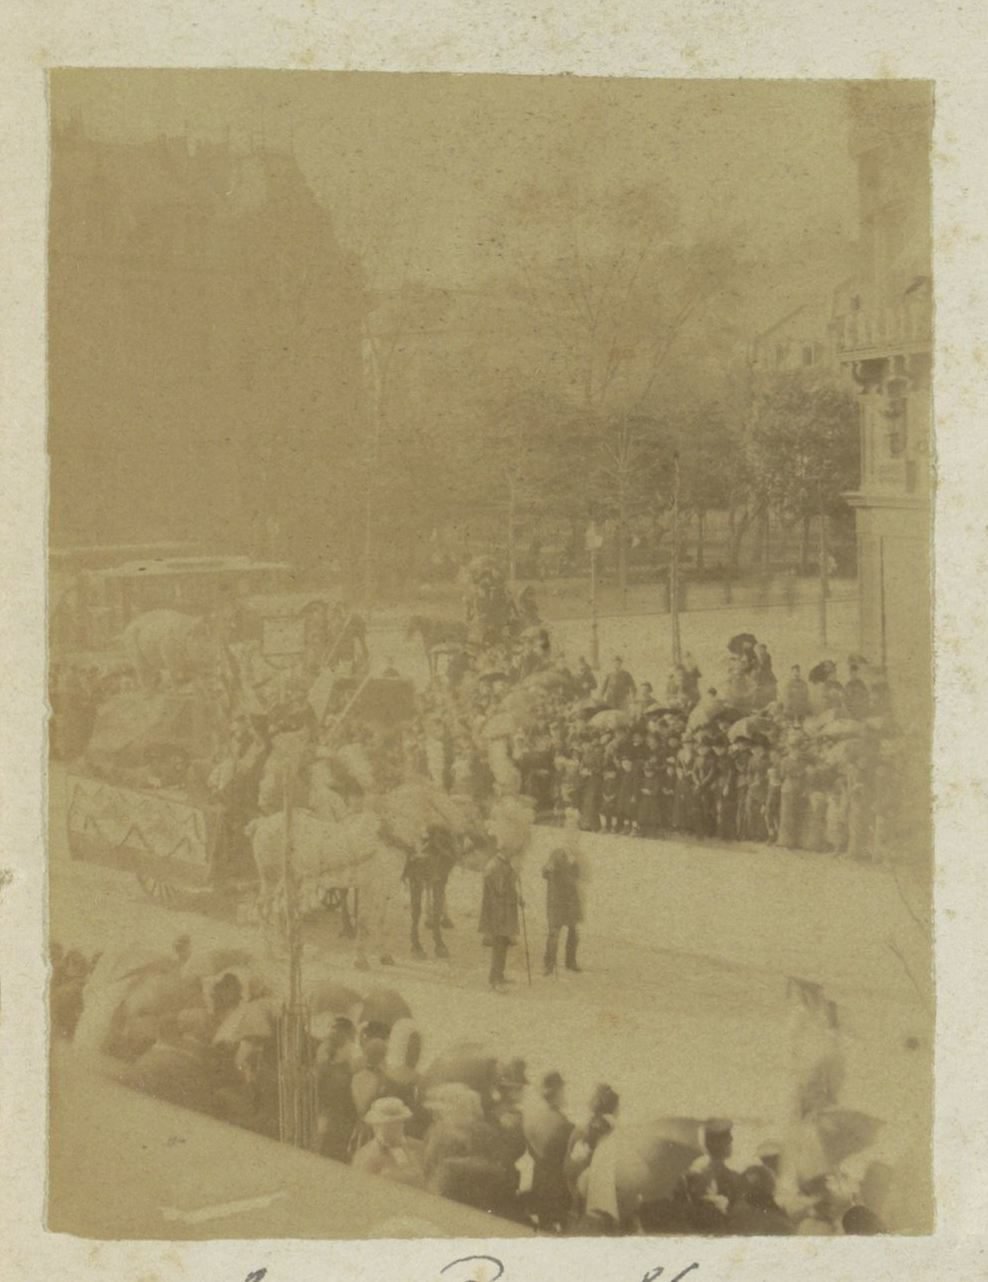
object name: photograph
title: Optocht in Le Havre ter gelegenheid van Paasmaandag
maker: Anonymous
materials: photographic support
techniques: albumen print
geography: le havre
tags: easter (non-liturgical celebration) (+ parade, pageant, cavalcade ~ festive activities), le havre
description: Onderdeel van Album van een Franse amateurfotograaf met opnames van familie, militairen, industrie, landschappen en bezienswaardigheden in Frankrijk.